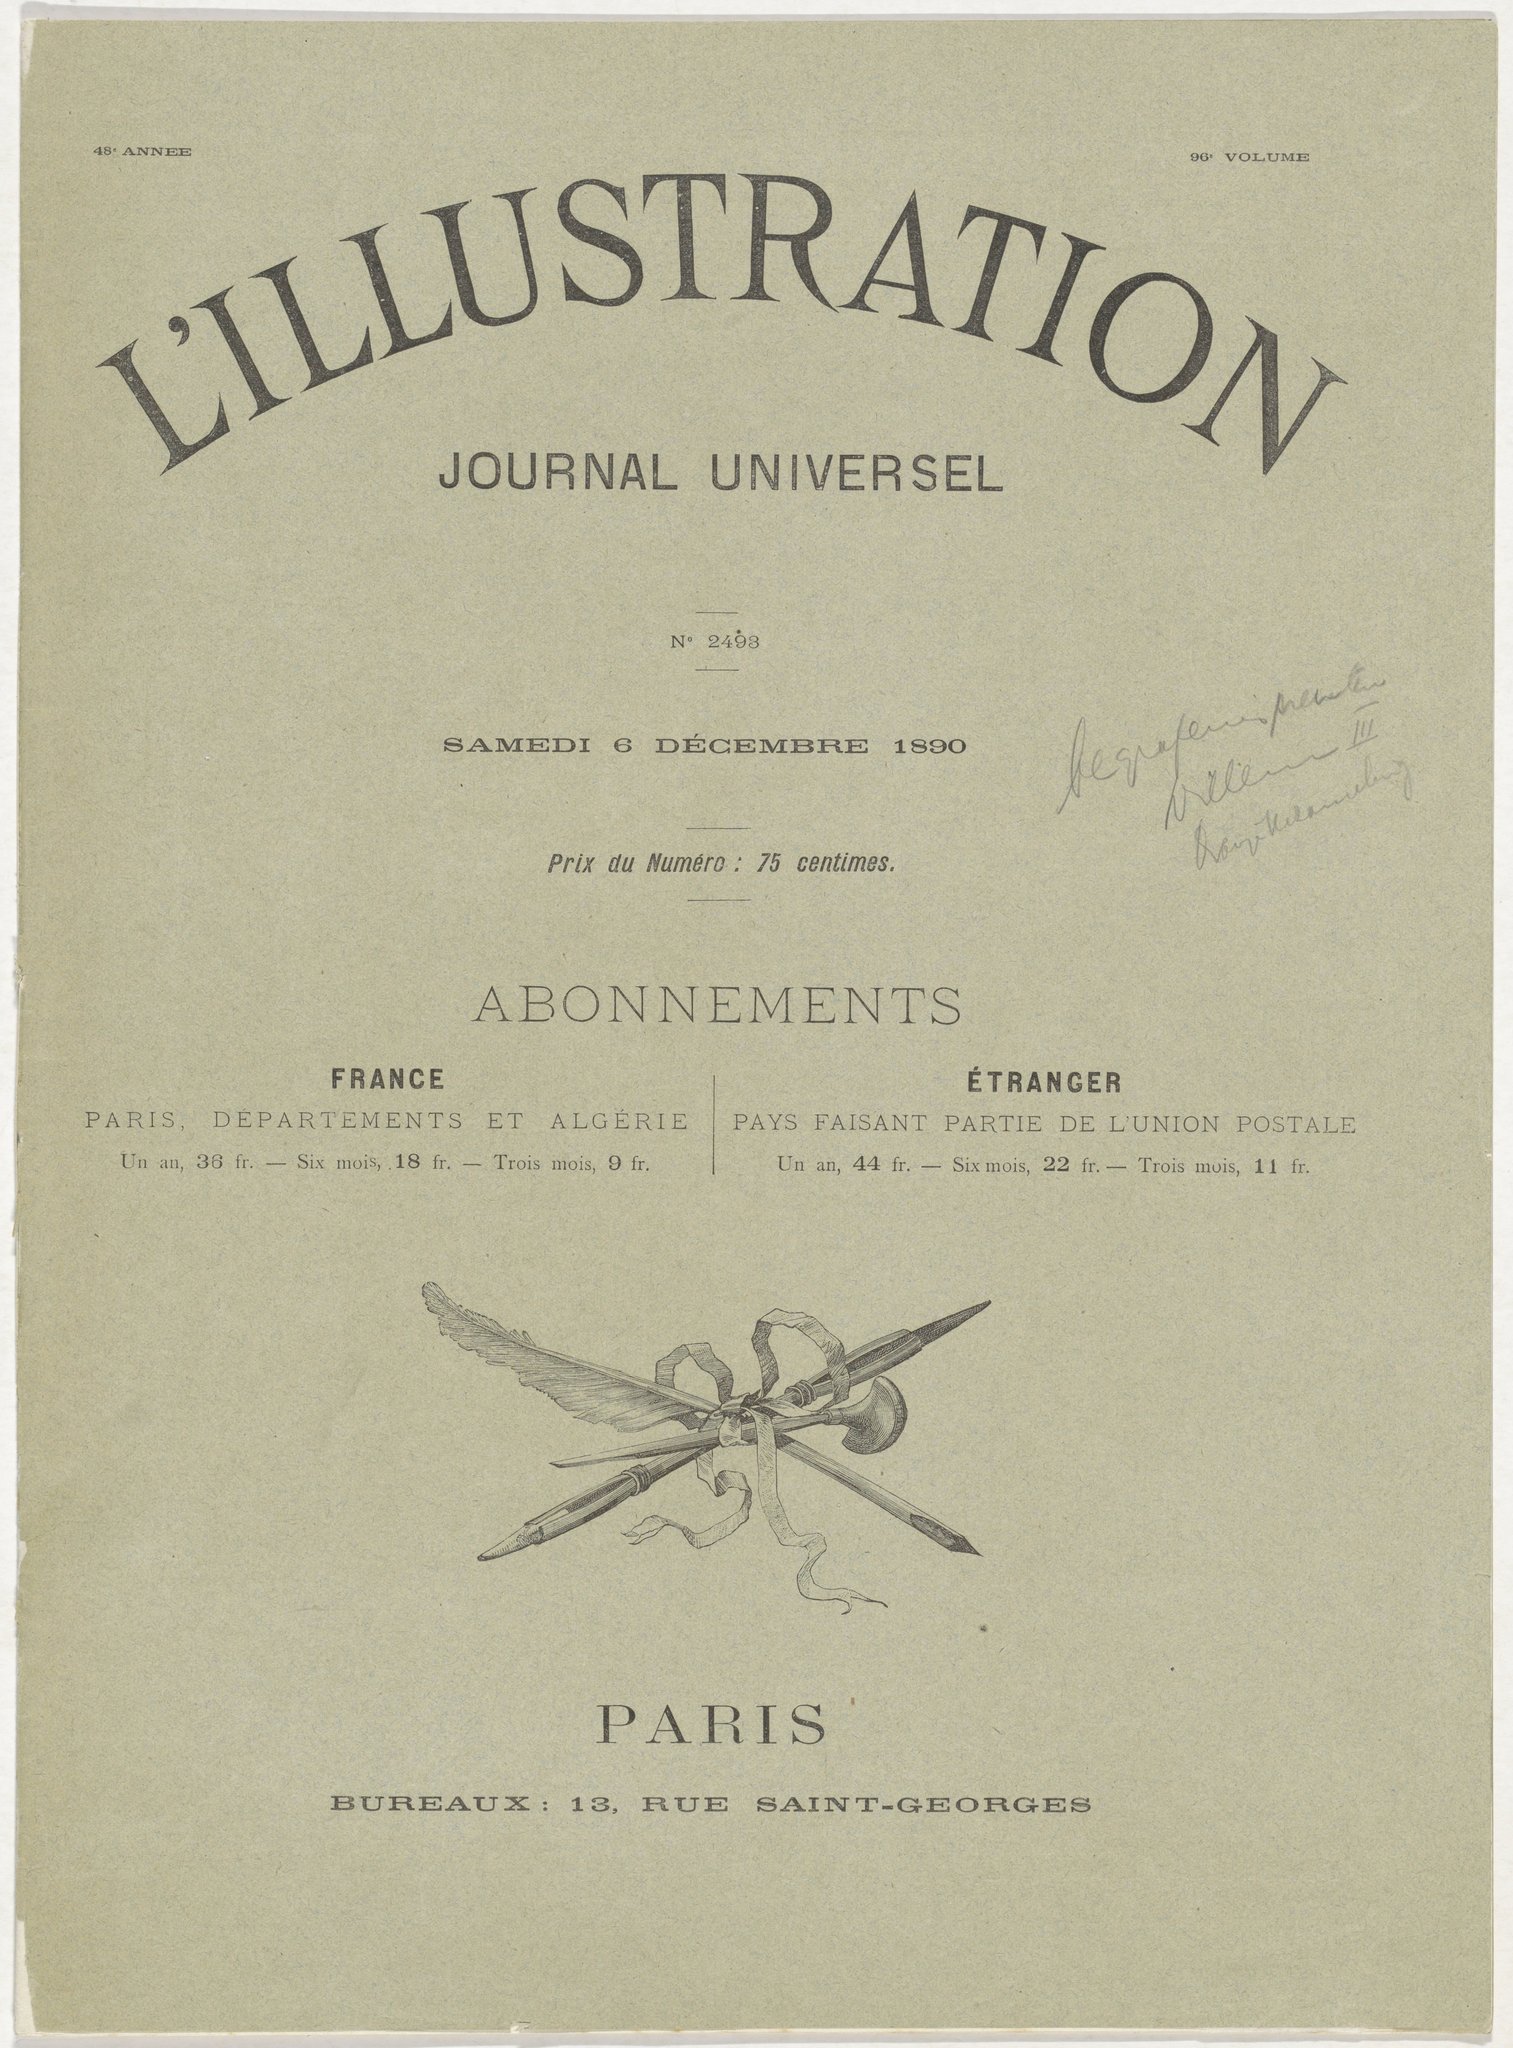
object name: newspaper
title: L'Illustration, Journal Universel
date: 1890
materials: paper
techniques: letterpress printing, engraving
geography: france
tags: brussels, willem iii (koning der nederlanden), funerary ceremonial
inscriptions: date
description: Krant met een artikel over de begrafenis van Willem III op 4 december 1890. Acht voorstellingen en kolommen en kaders met Franse tekst in boekdruk.